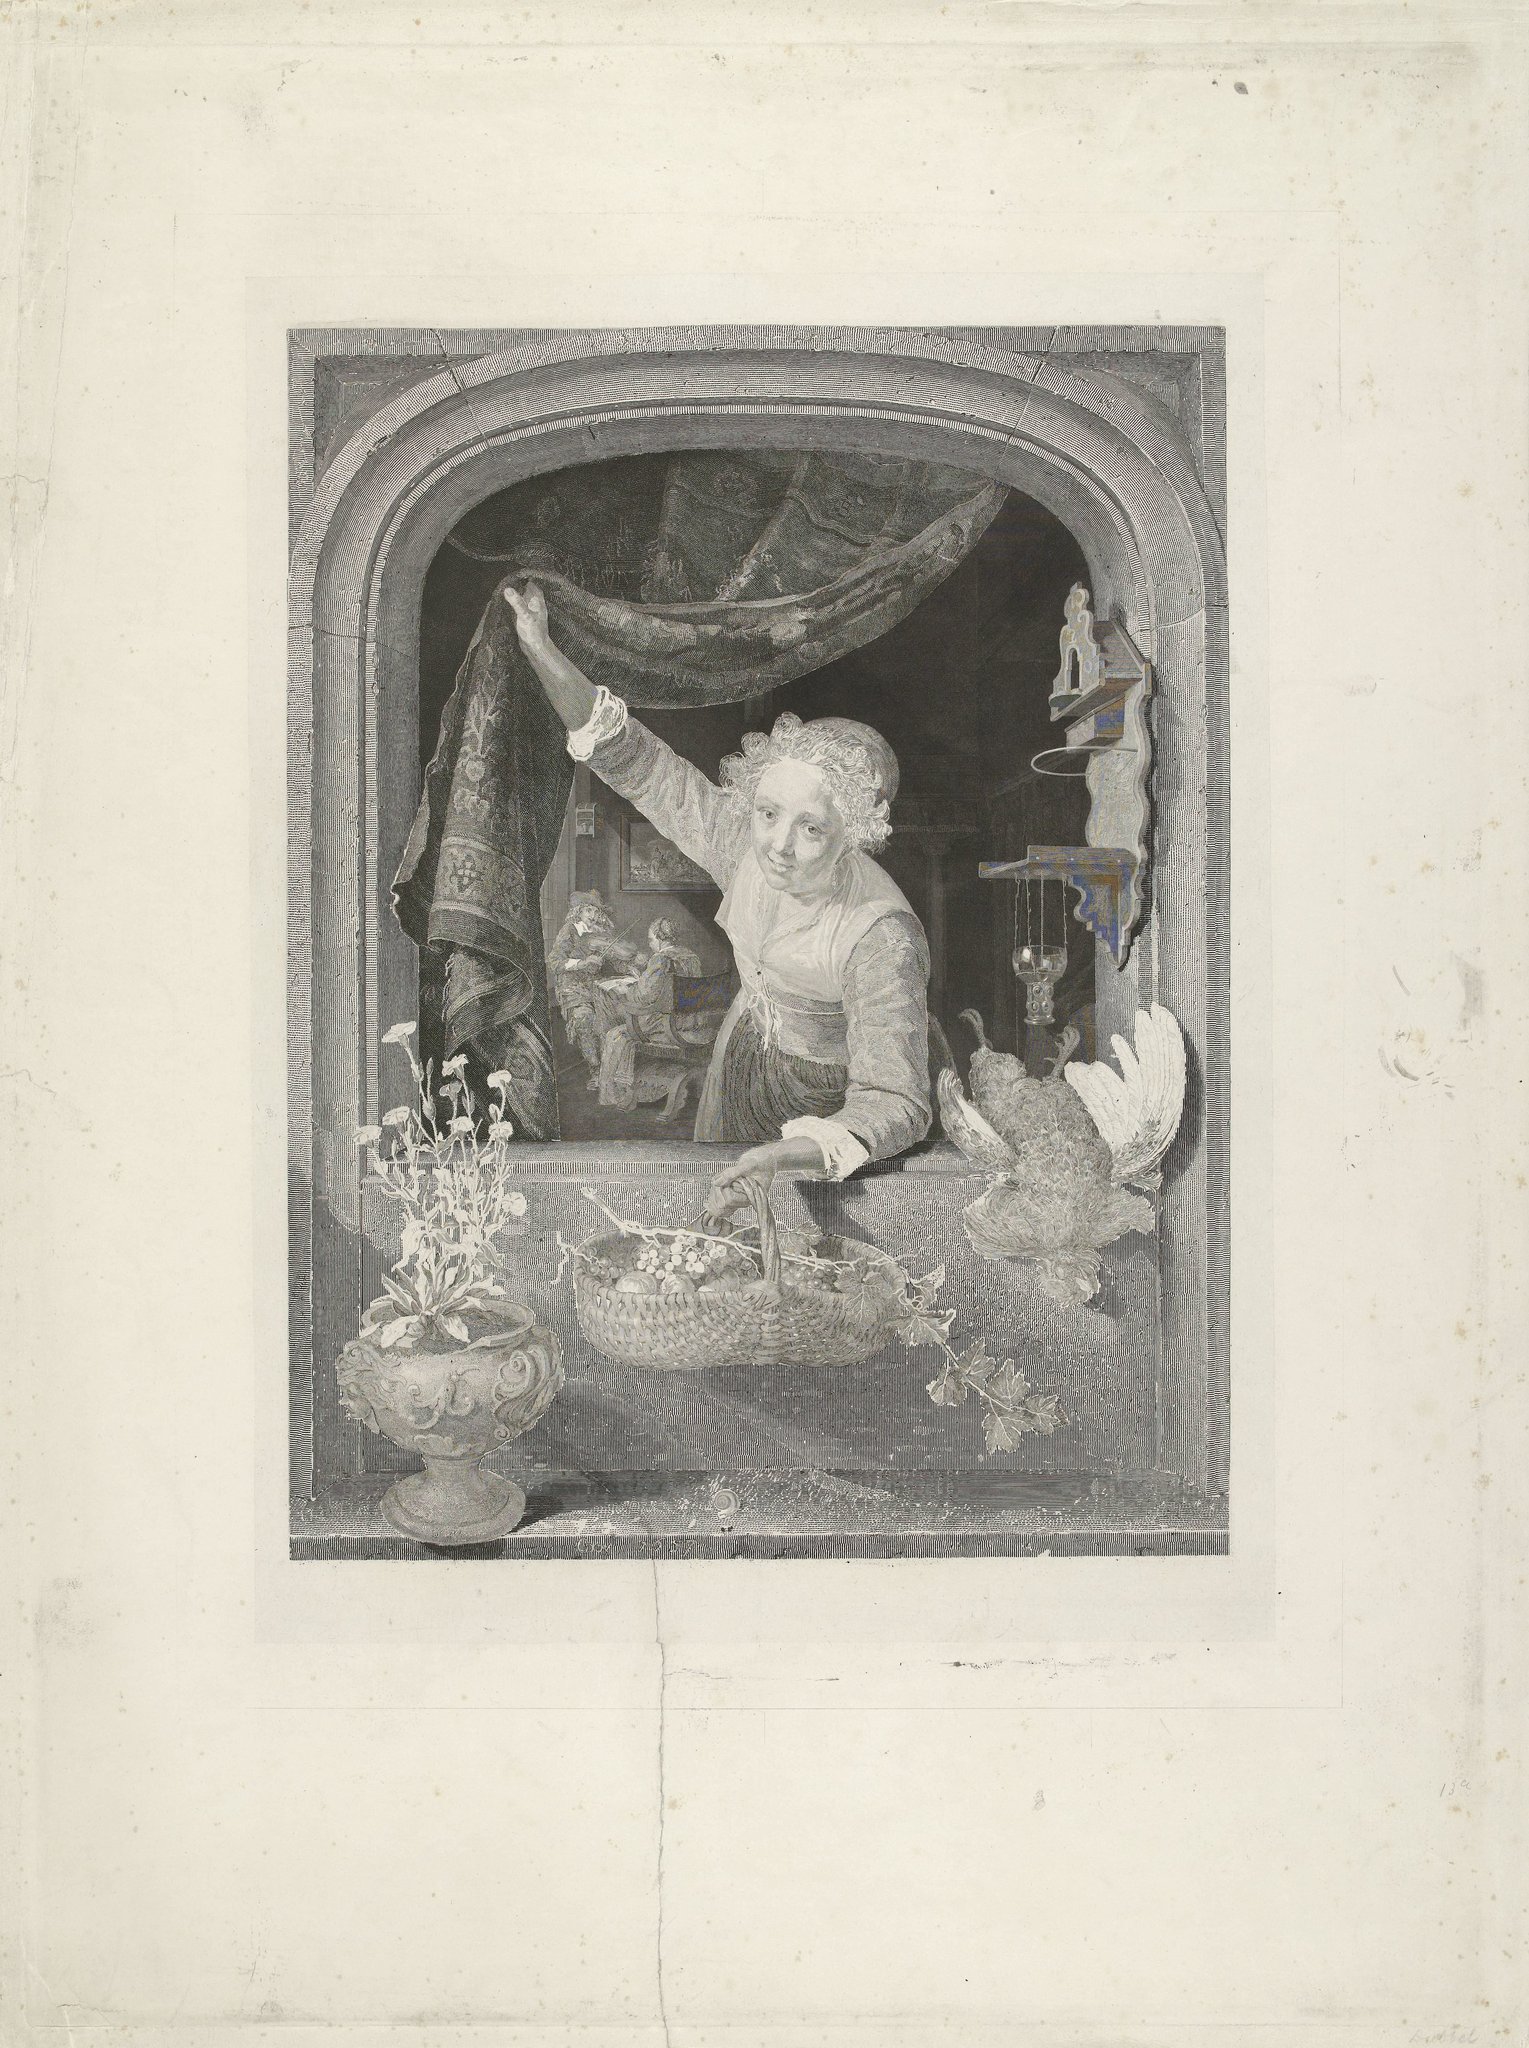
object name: print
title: Vrouw met mand met vruchten in de hand bij het raam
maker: henricus wilhelmus couwenberg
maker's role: draughtsman, print maker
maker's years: 1814-1845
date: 1842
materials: paper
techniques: etching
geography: amsterdam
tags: instrumental and vocal music together, human figure at (open) window, seen from outside, shop-window, show-window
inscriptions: collector's mark: Lugt 2228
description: Een jonge vrouw met een mand met vruchten in de hand hangt uit een venster. Ze houdt het gordijn opzij zodat het interieur achter haar zichtbaar is. In het vertrek zijn een man en een vrouw aan het musiceren. In de vensterbank hangt een vogelhuis, ligt een dode haan en staat een vaas met bloemen.